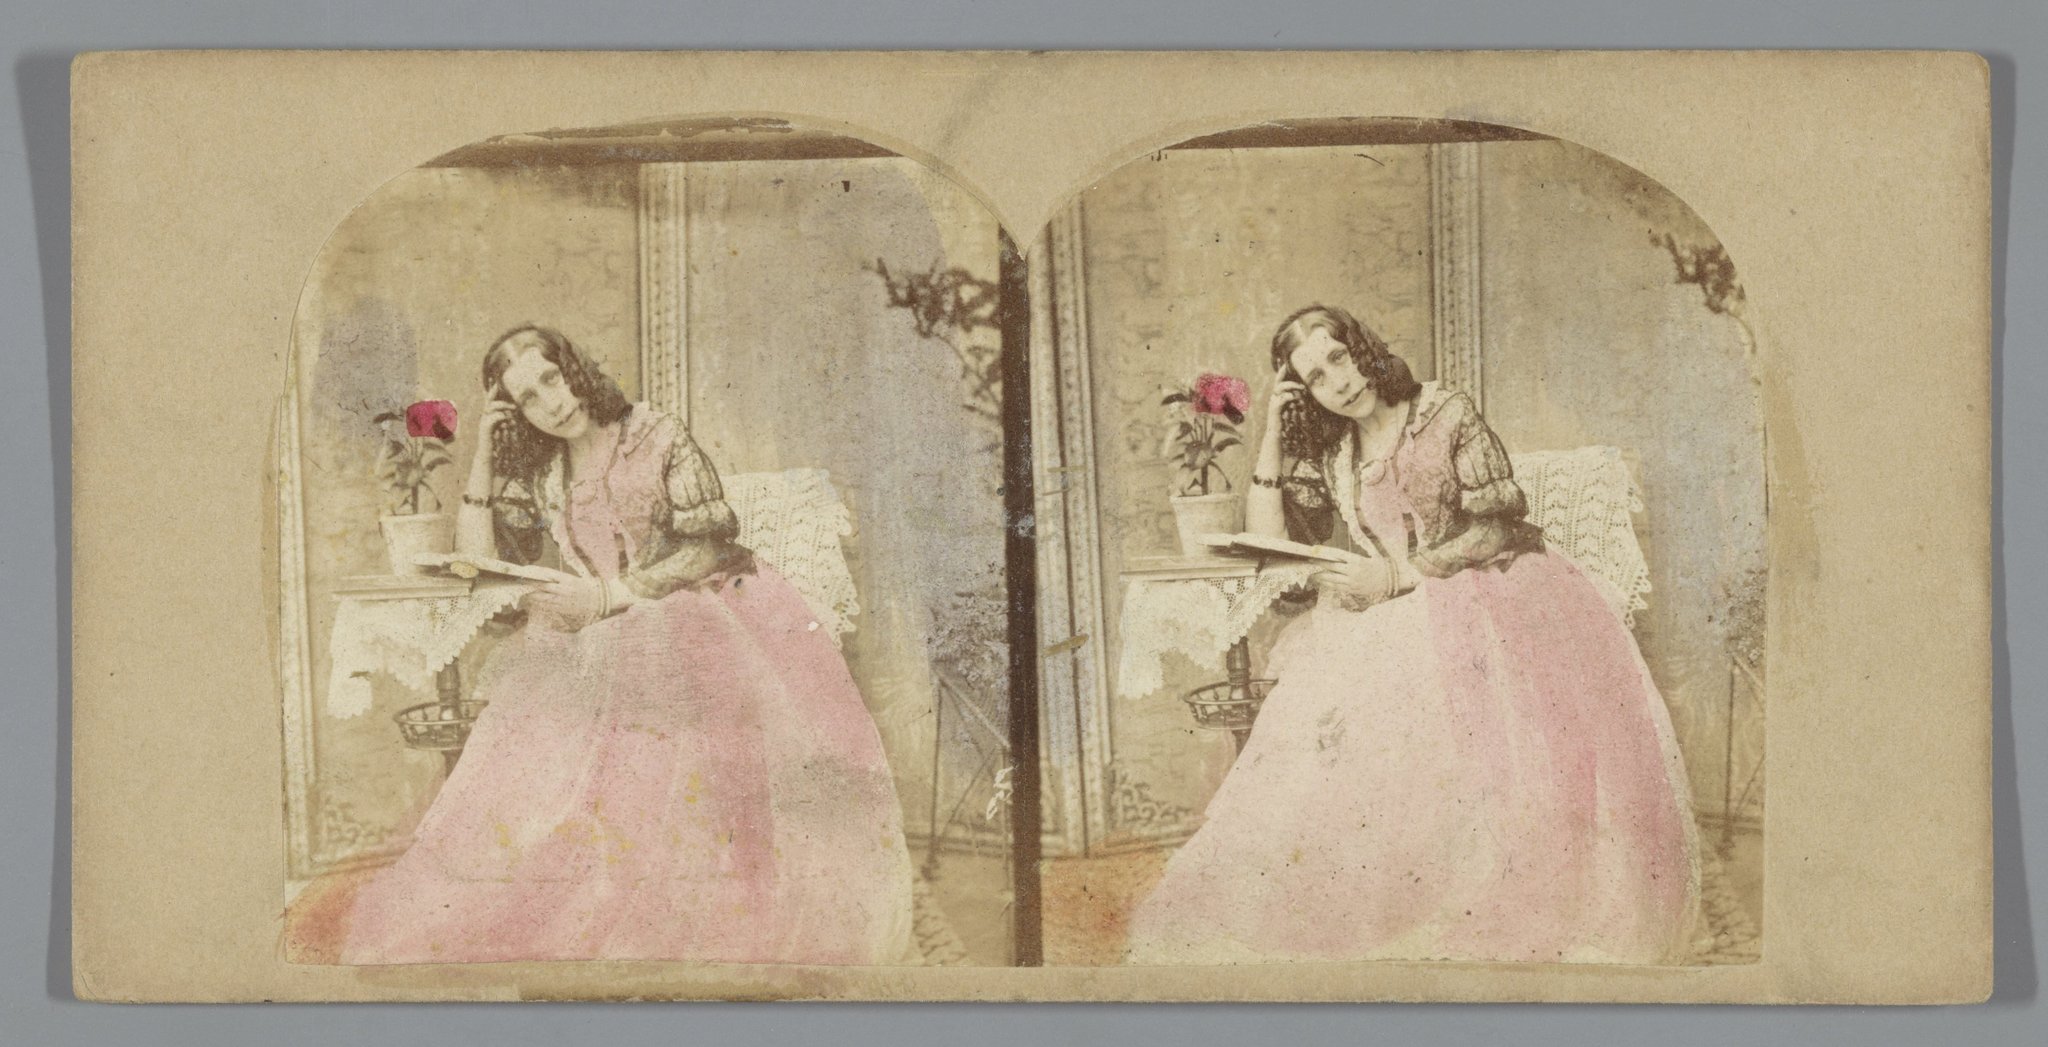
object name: stereograph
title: Zittende vrouw met een boek aan een tafeltje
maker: Anonymous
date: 1852-1863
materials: cardboard, paper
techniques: albumen print, hand coloring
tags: adult woman